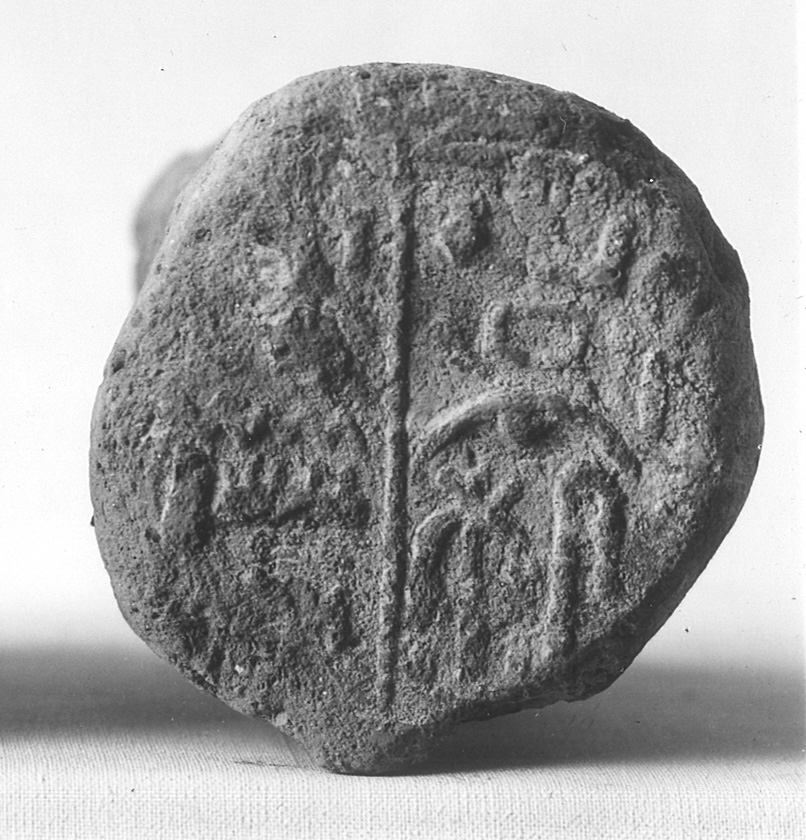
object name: cone, ahmose, tt 121, circular impression, prophet, amun, thutmose iii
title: Funerary Cone of the High Priest Ahmose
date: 1479-1425 BCE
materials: pottery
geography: egypt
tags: hieroglyphs